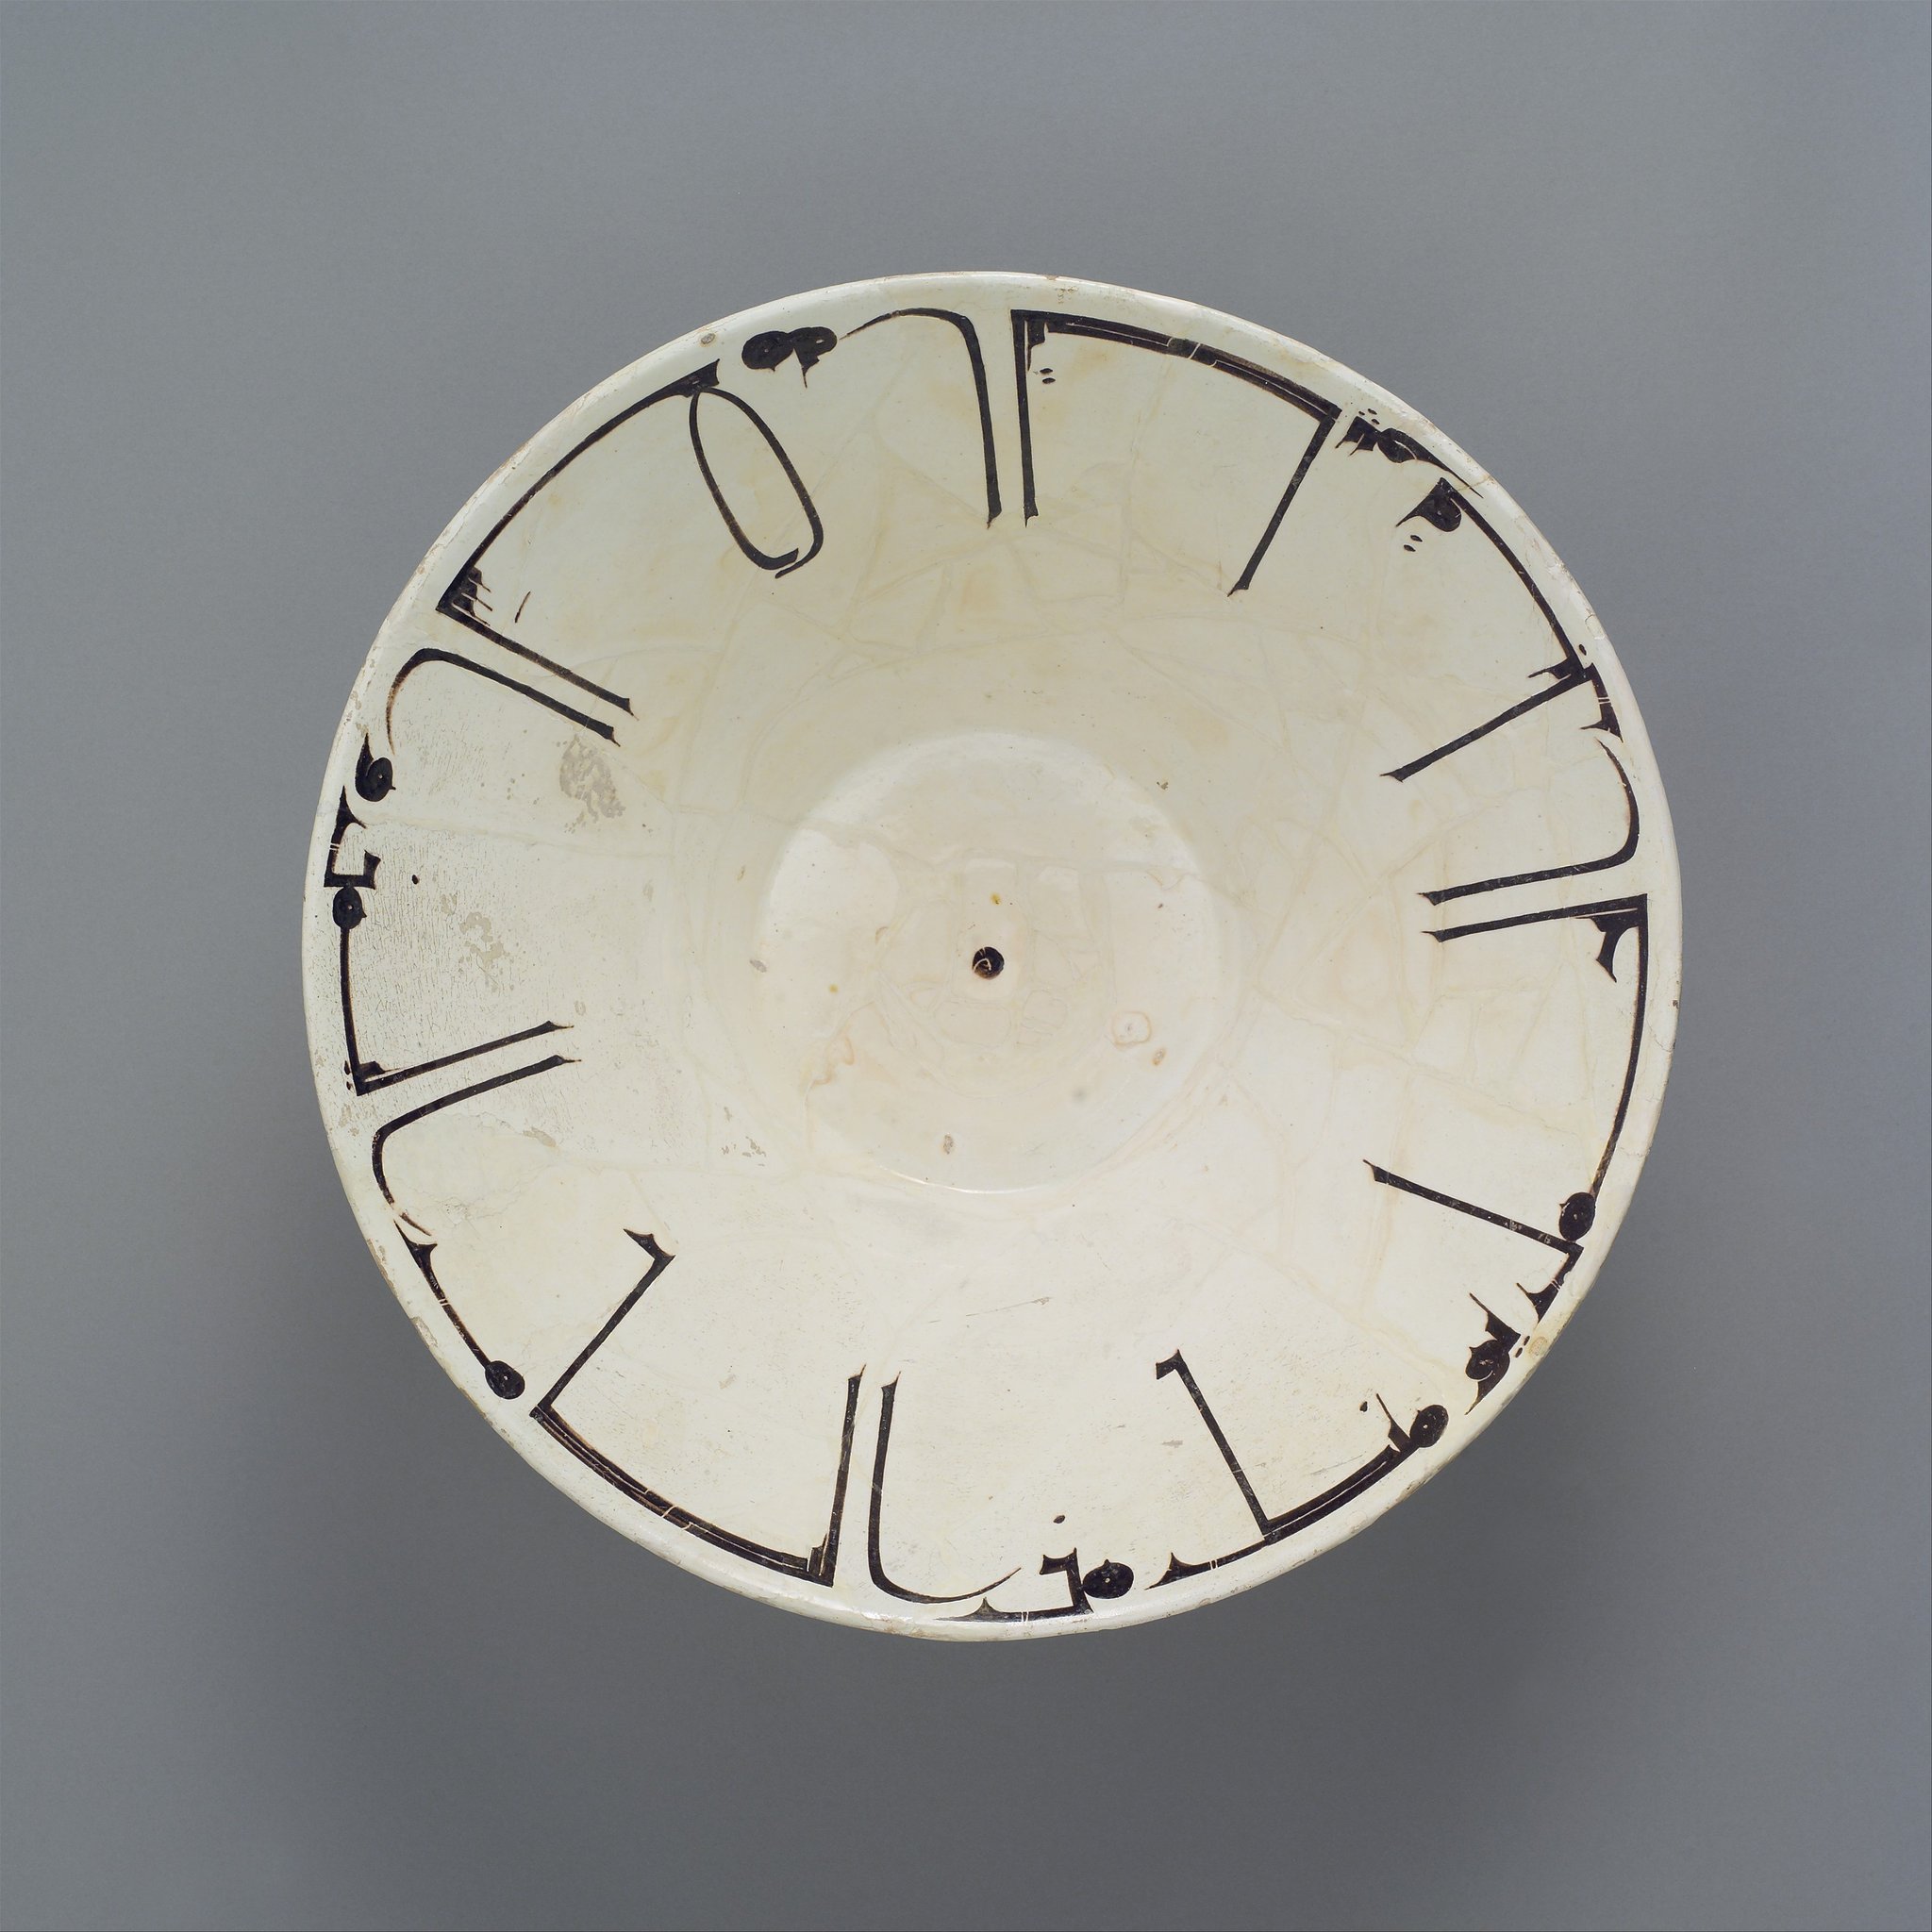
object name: bowl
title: Bowl with Arabic Inscription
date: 901-1000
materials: earthenware, glaze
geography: iran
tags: arabic